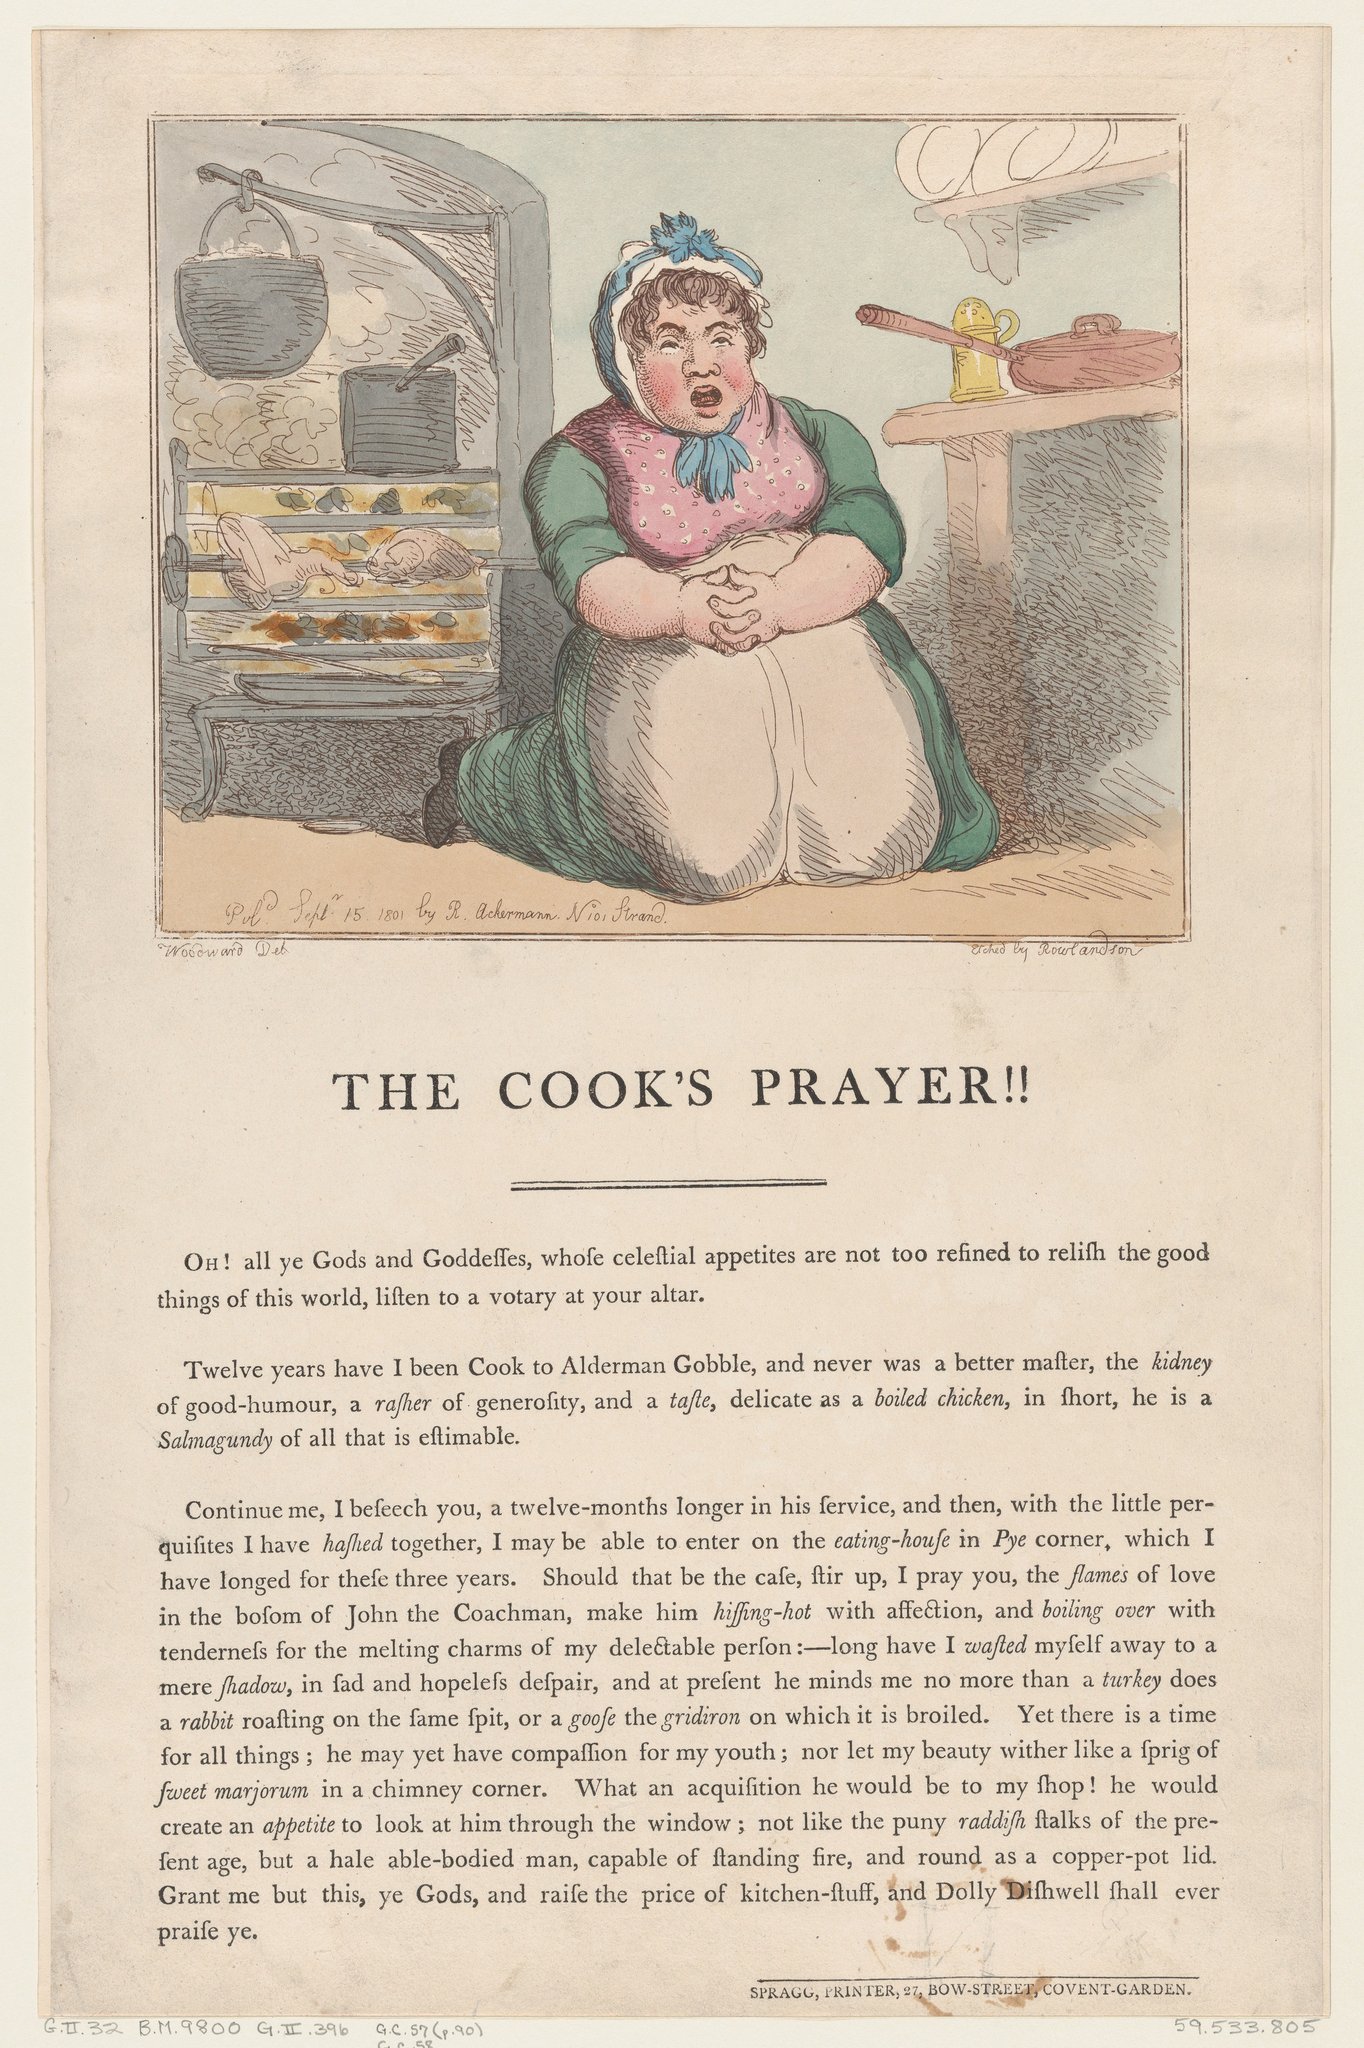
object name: print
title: The Cook's Prayer!!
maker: thomas rowlandson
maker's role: artist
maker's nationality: british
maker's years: 1757-1827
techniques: etching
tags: satire,kitchens,women